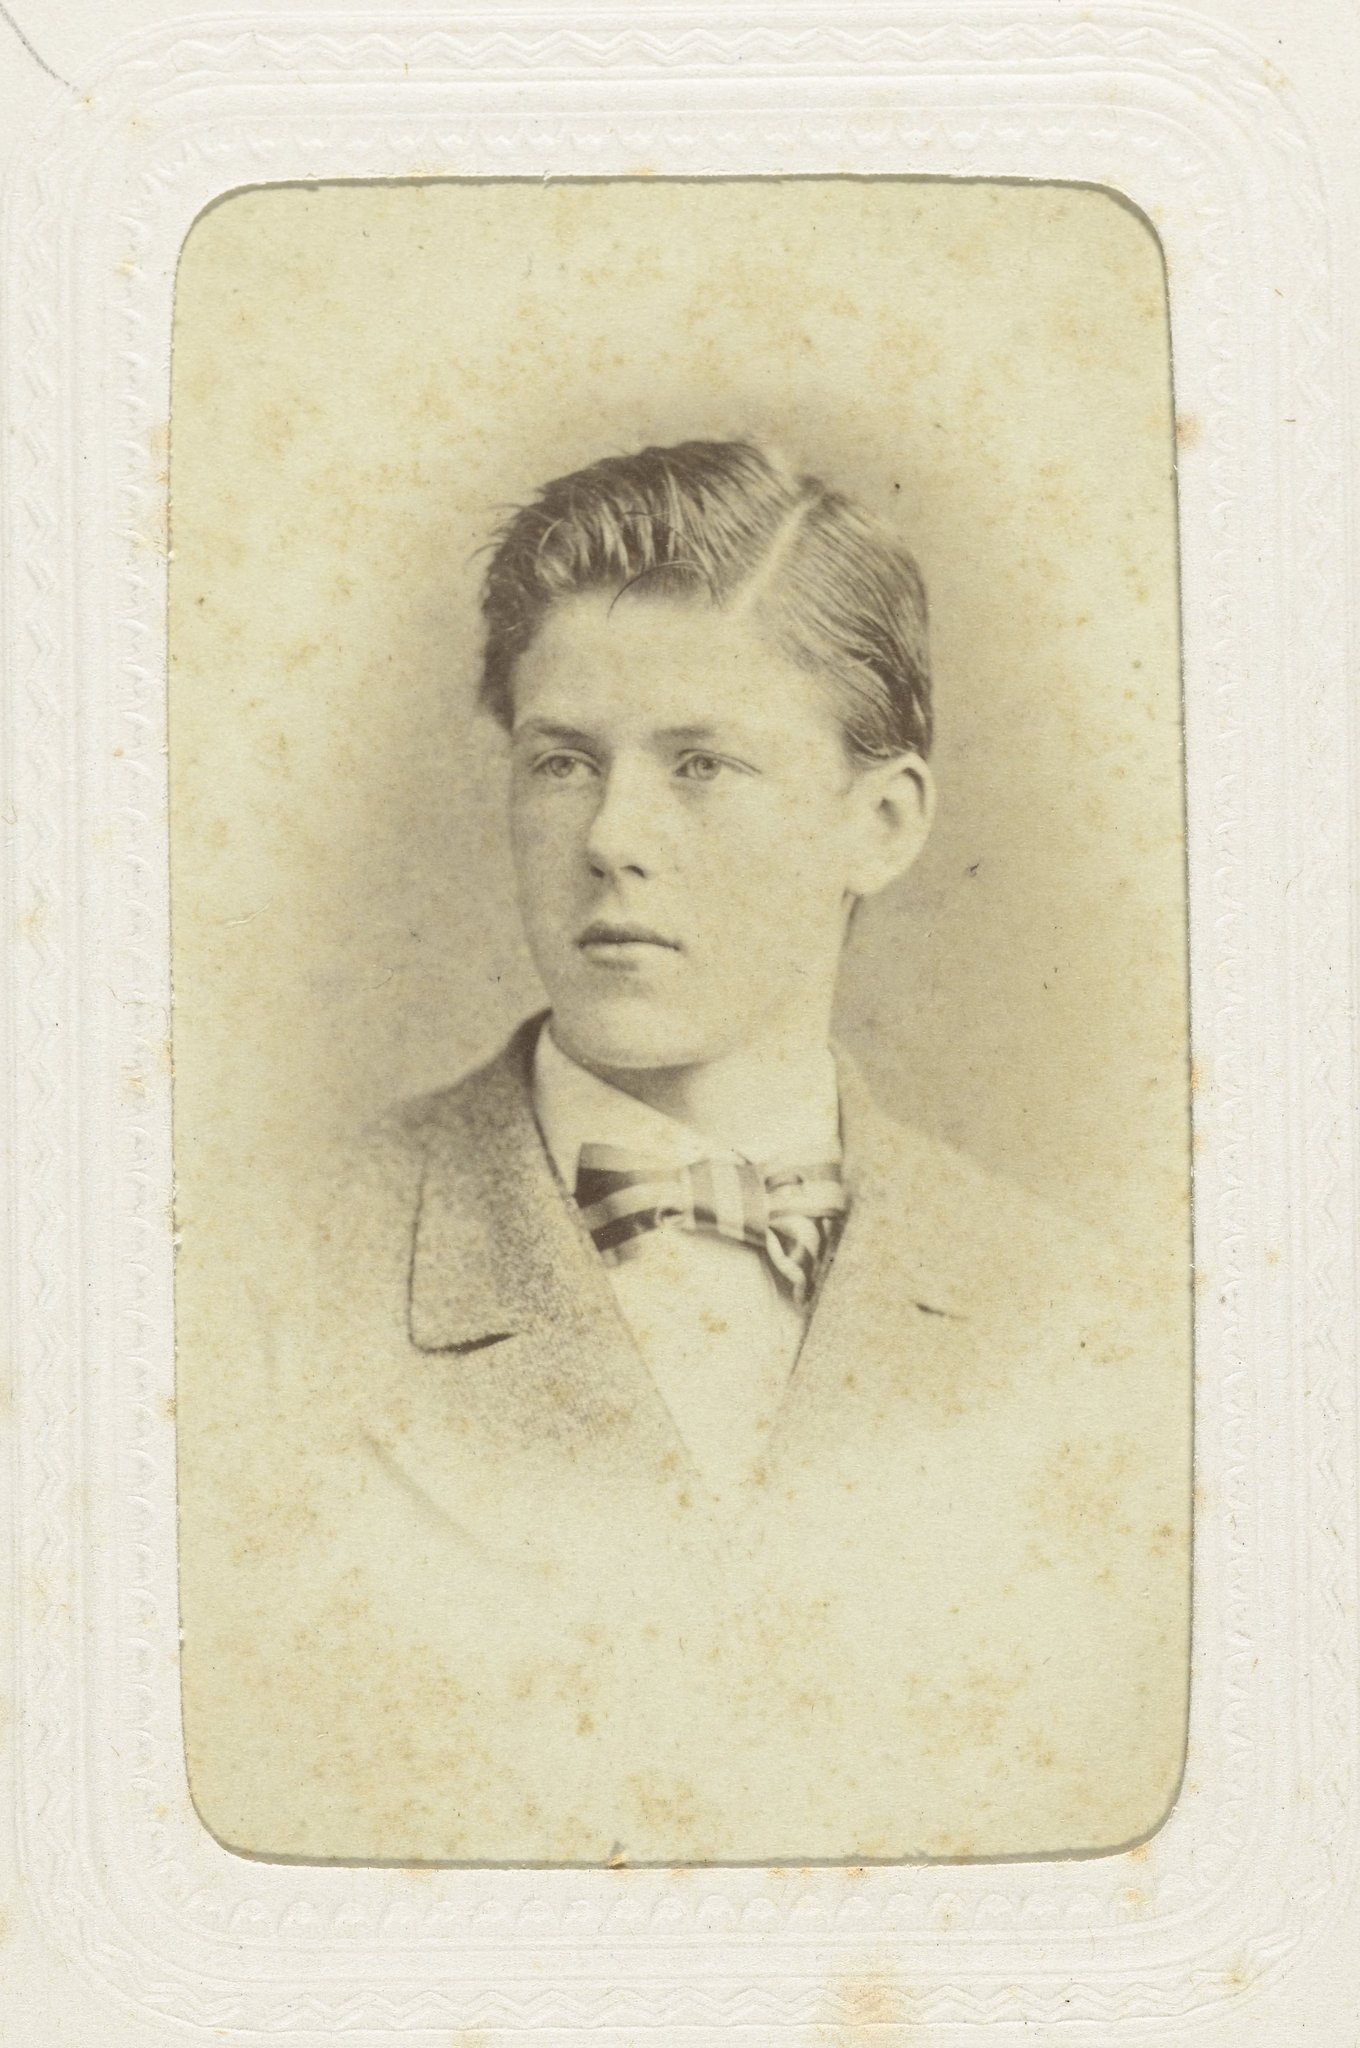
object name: carte de visite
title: Studioportret van een jongeman in een colbert met een geruite strik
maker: albert greiner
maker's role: fotograaf, fotostudio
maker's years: 1833-1890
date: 1863-1866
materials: cardboard, paper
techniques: albumen print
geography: amsterdam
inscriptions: name: ‘Albert Greiner Amsterdam’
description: De jongeman heeft een strakke scheiding in zijn haar gekamd.